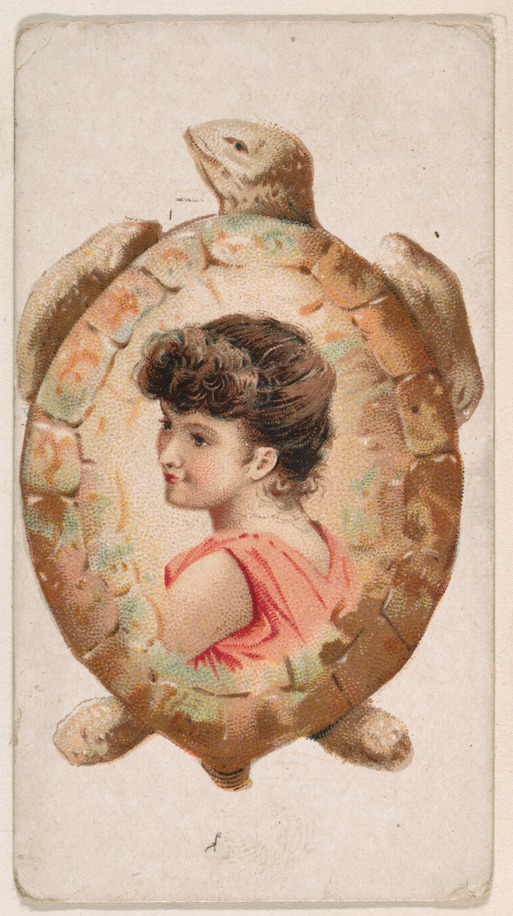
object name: print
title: Turtle, from the Novelties series (N228, Type 5) issued by Kinney Bros.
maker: kinney brothers tobacco company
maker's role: publisher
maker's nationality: american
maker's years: 1869-2011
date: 1889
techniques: color lithograph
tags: profiles,women,turtles